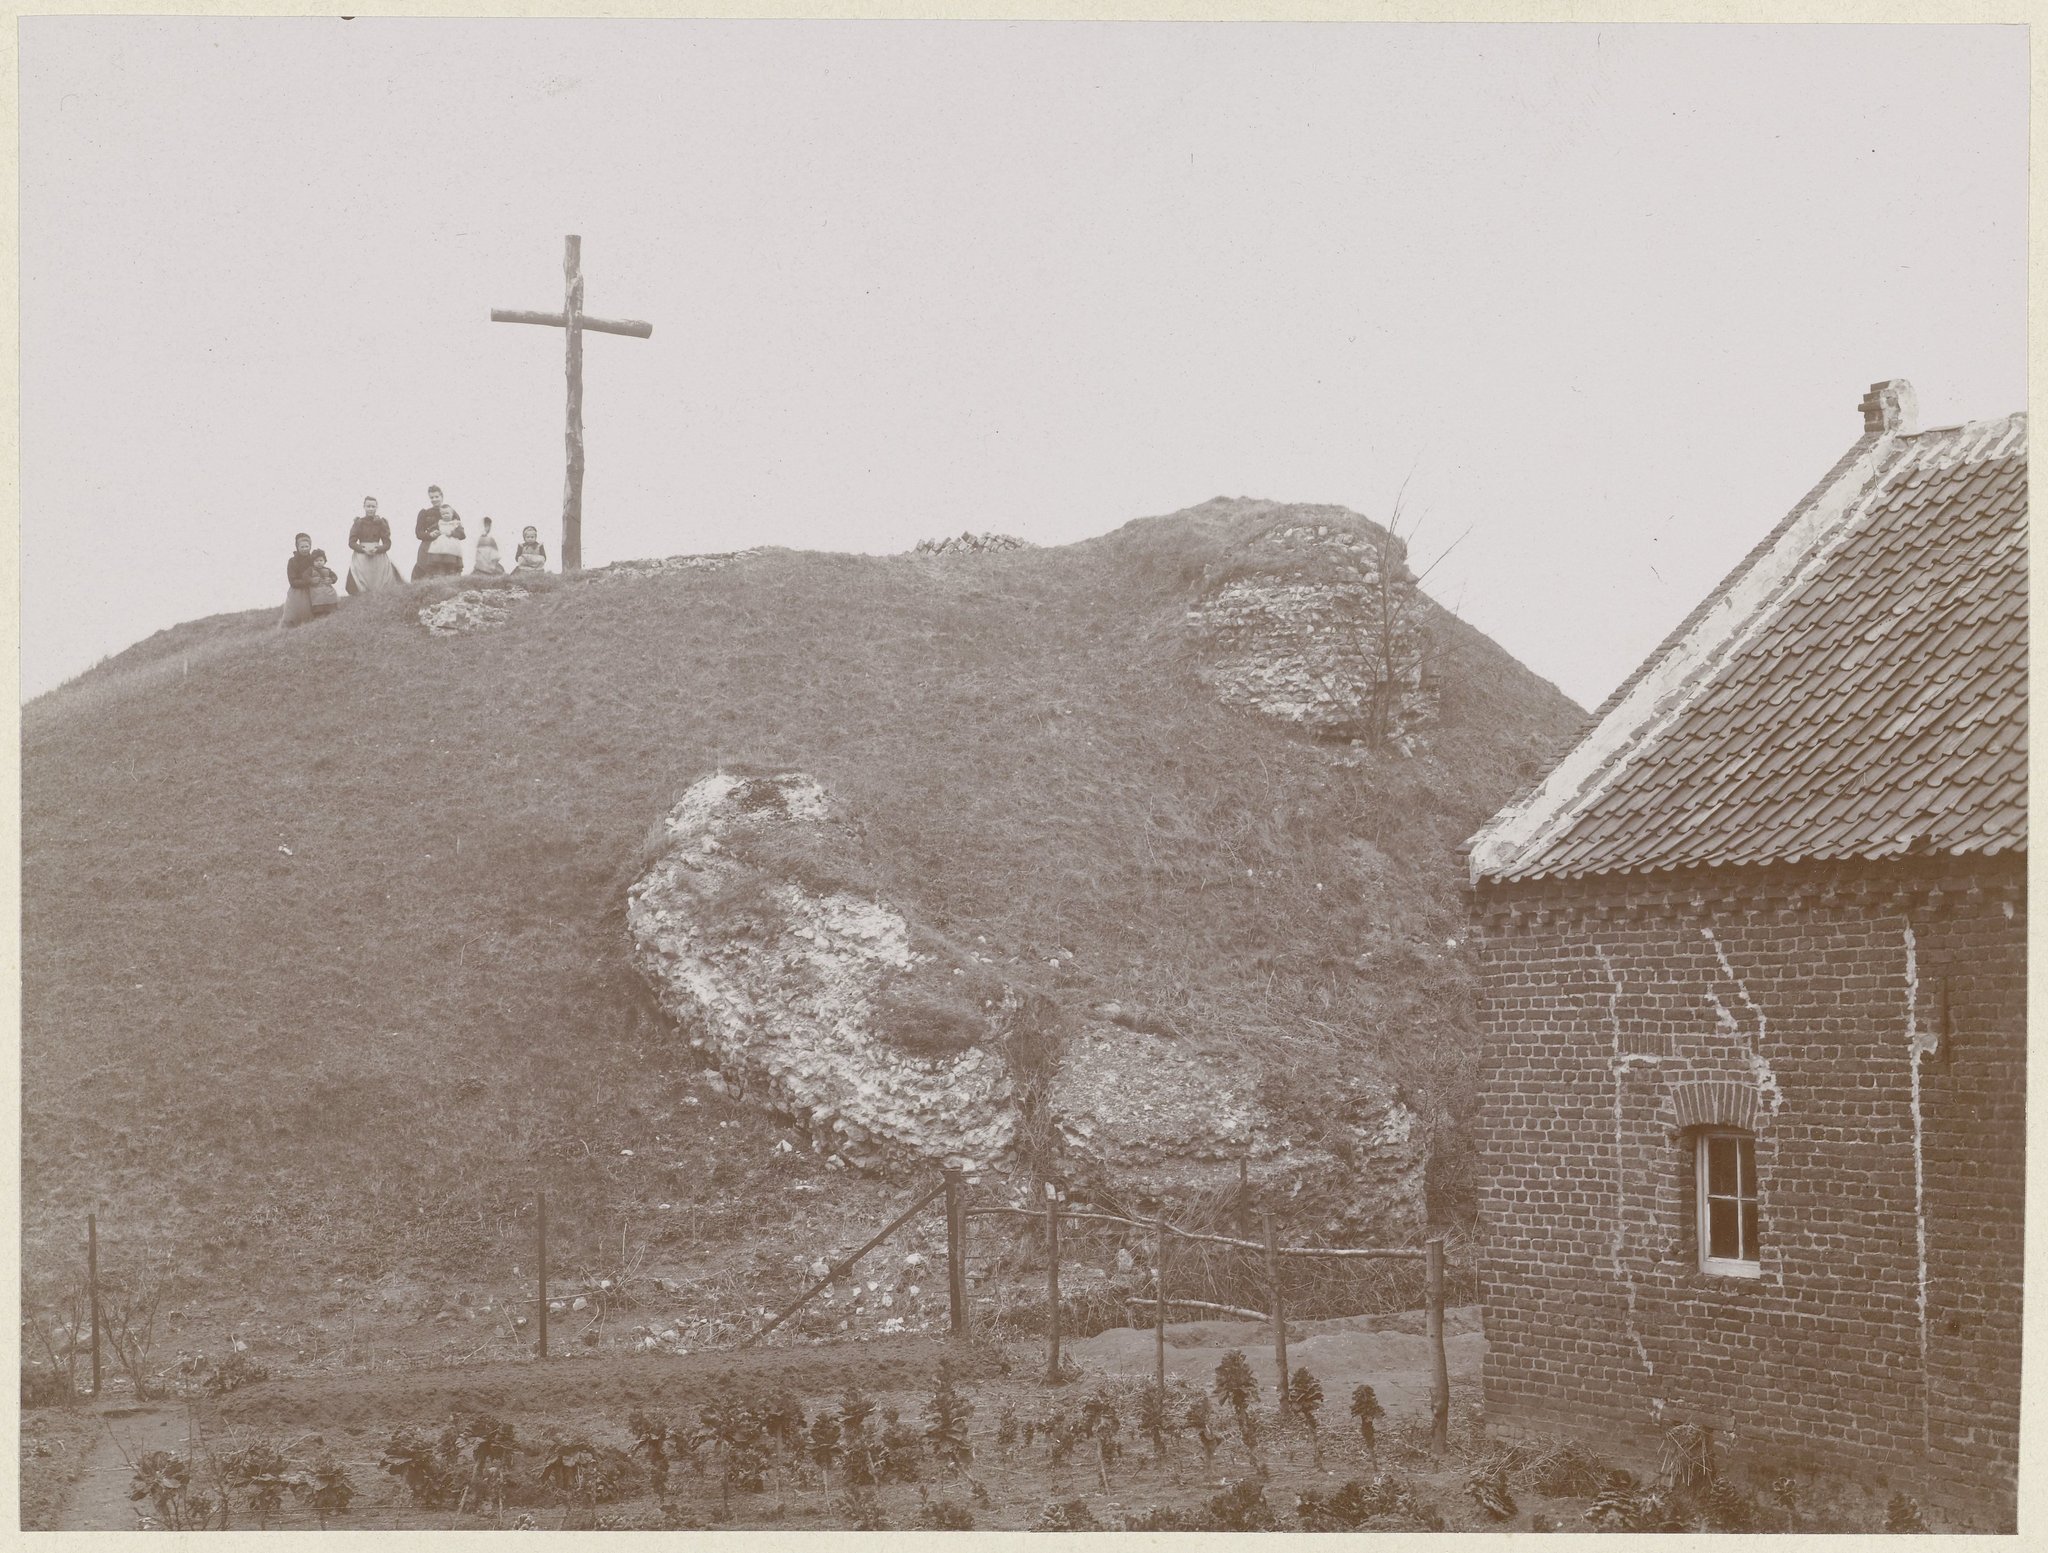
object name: photograph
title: Houten kruis op de ruïne van het kasteel te Kessenich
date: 1890-1898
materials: cardboard, photographic support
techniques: gelatin silver print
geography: kessenich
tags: (public) prayer, castle, ruin of a building ~ architecture, other kinds of grave-markers, e.g. cross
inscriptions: annotation: ‘Kessenich Belgie. Overblijfselen van het oude kasteel/ A.J.M. Mulder (toegeschreven)’, annotation: ‘Kessenich’